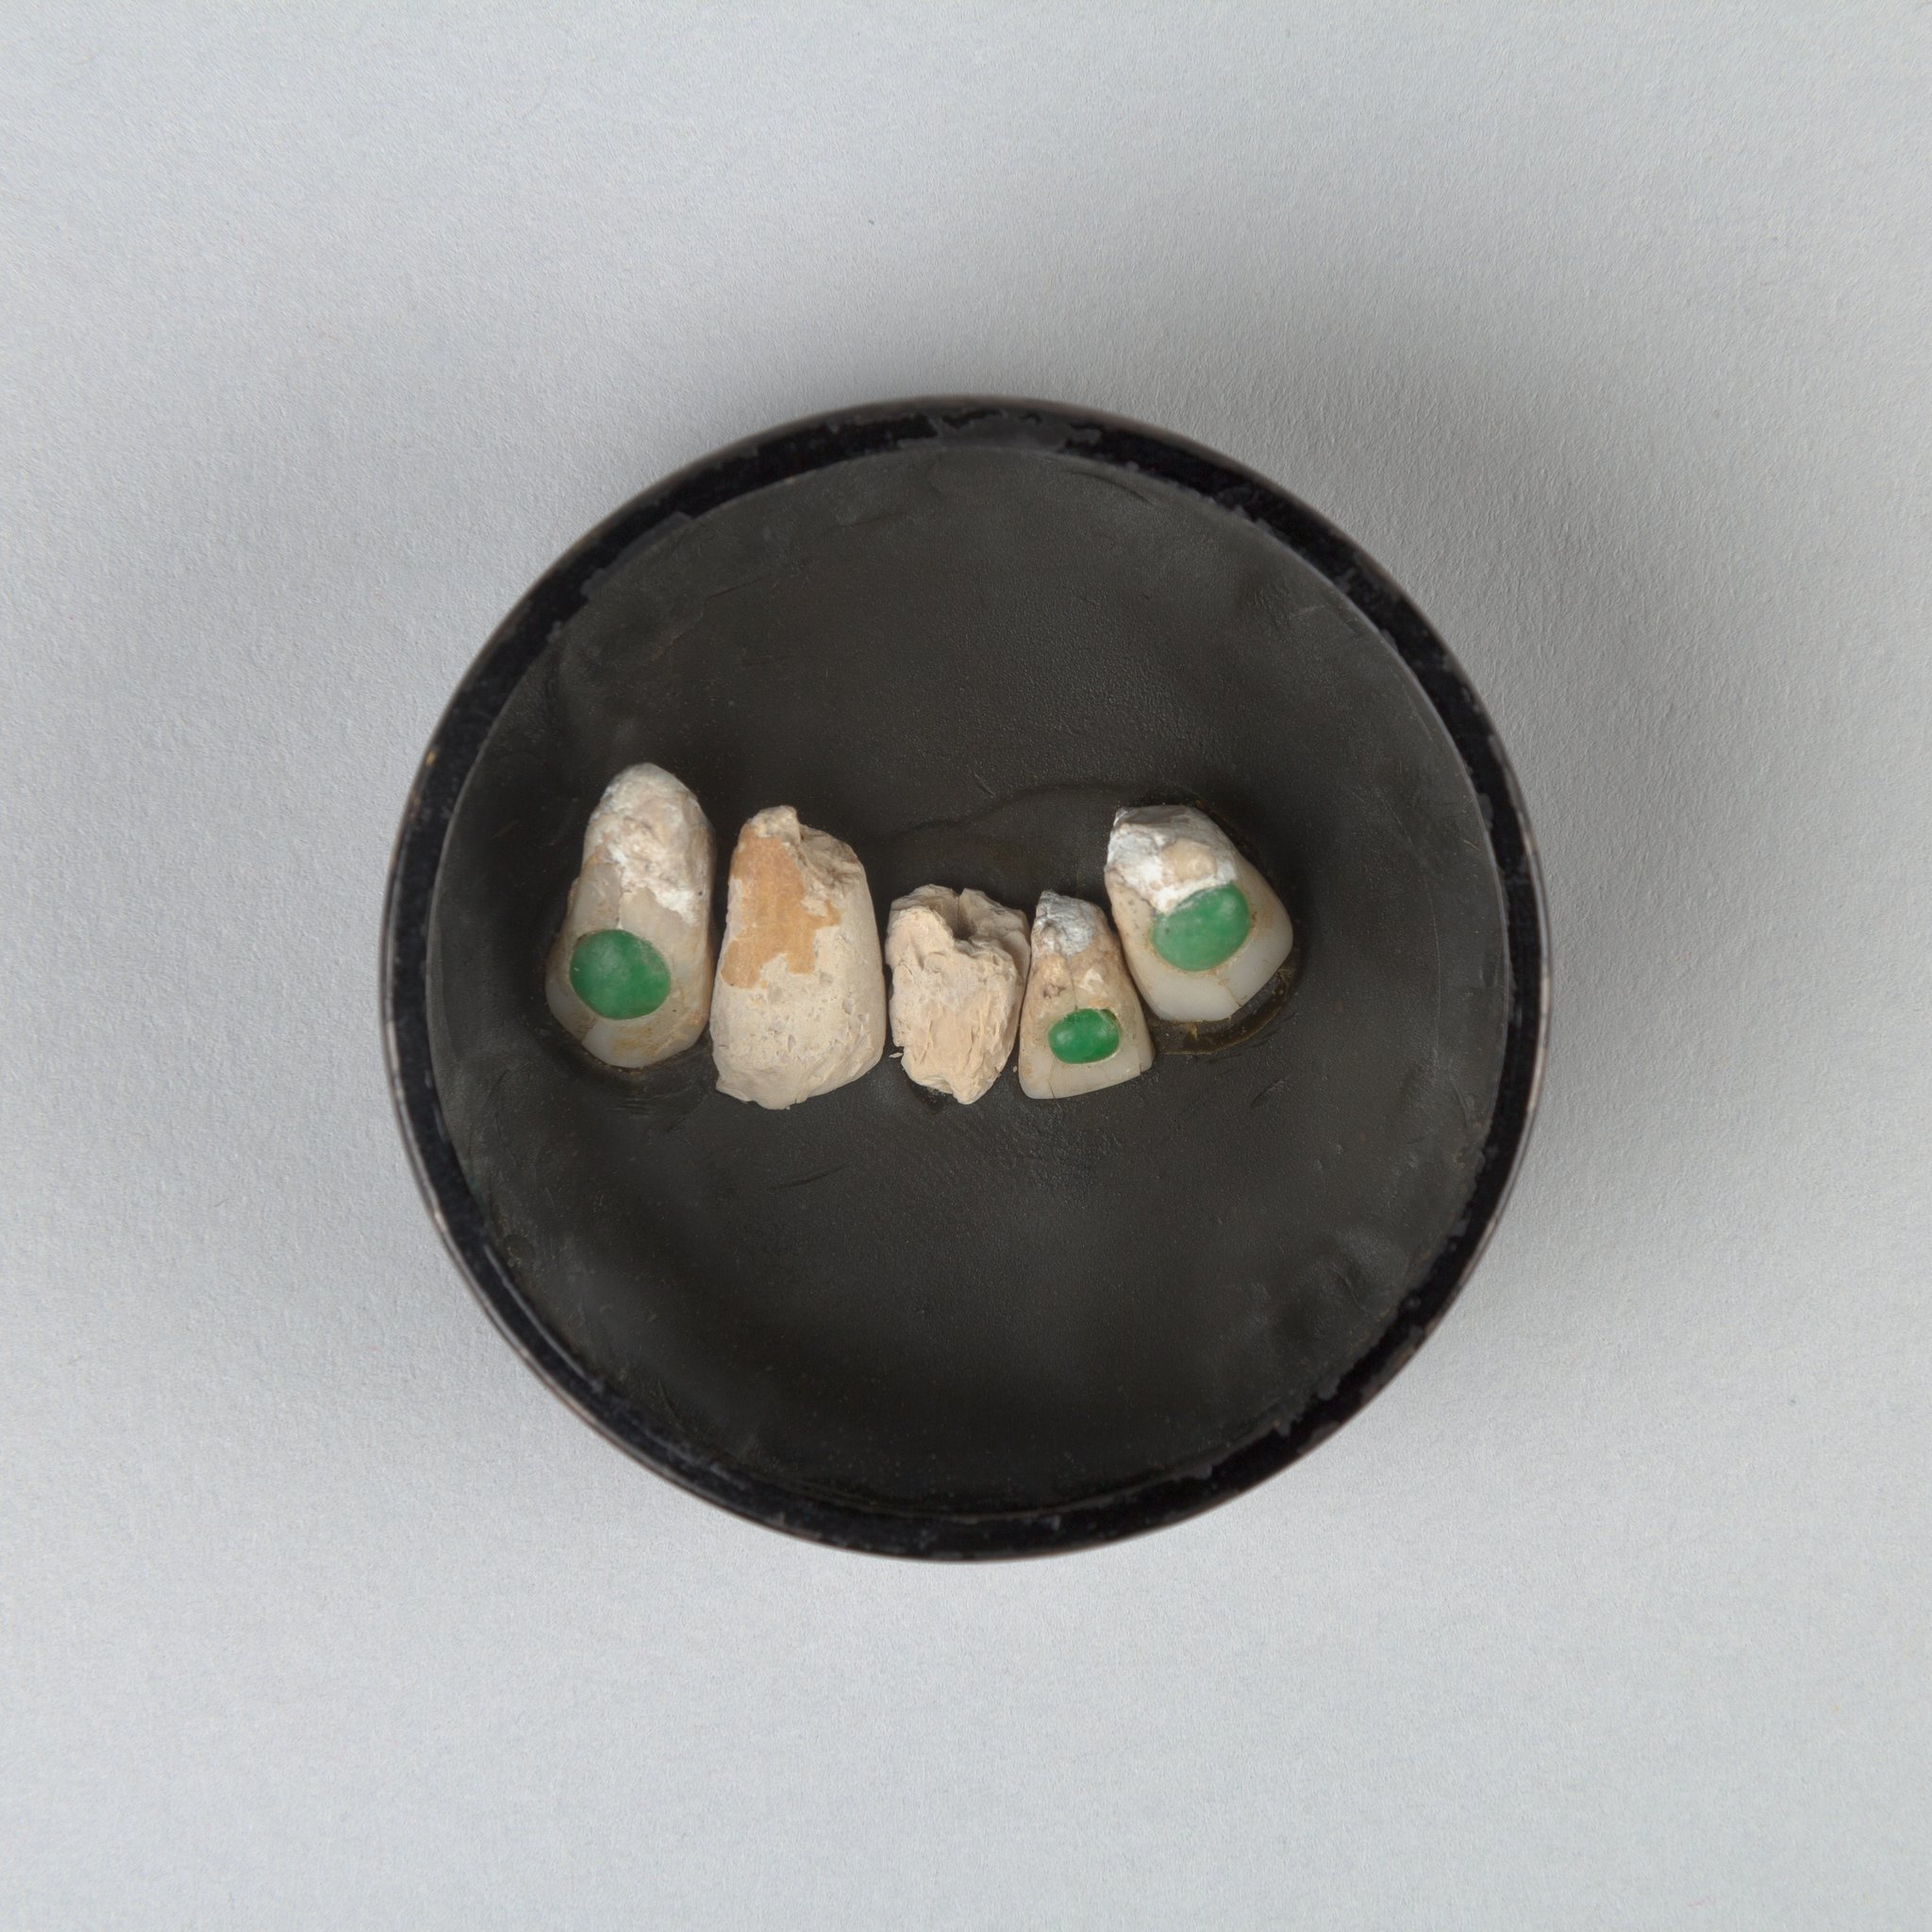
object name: human tooth inlaid with jadeite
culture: mexican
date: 1902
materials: jade